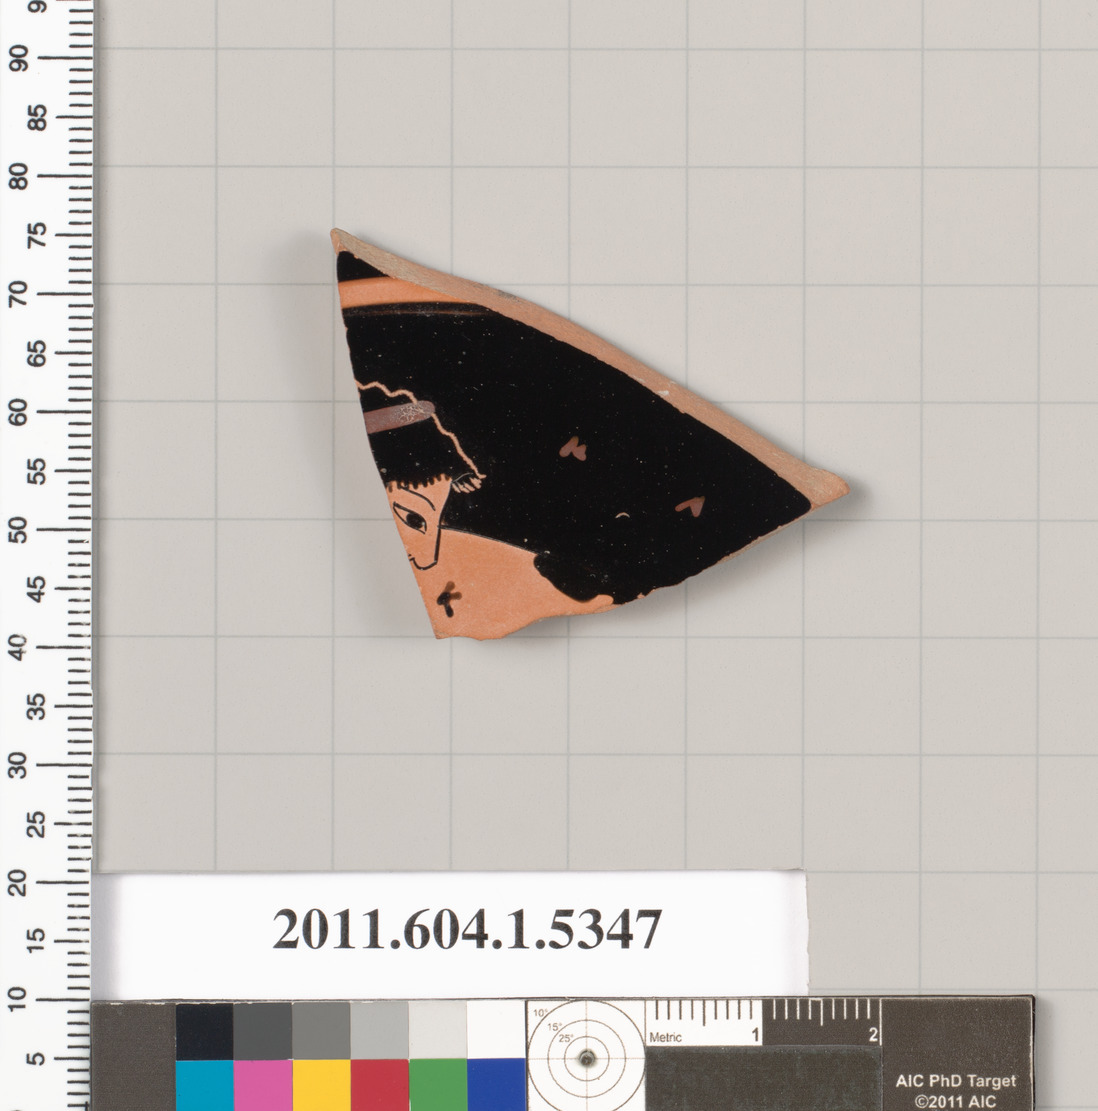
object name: kylix fragment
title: Terracotta fragment of a kylix (drinking cup)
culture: greek, attic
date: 500-490 BCE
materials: terracotta